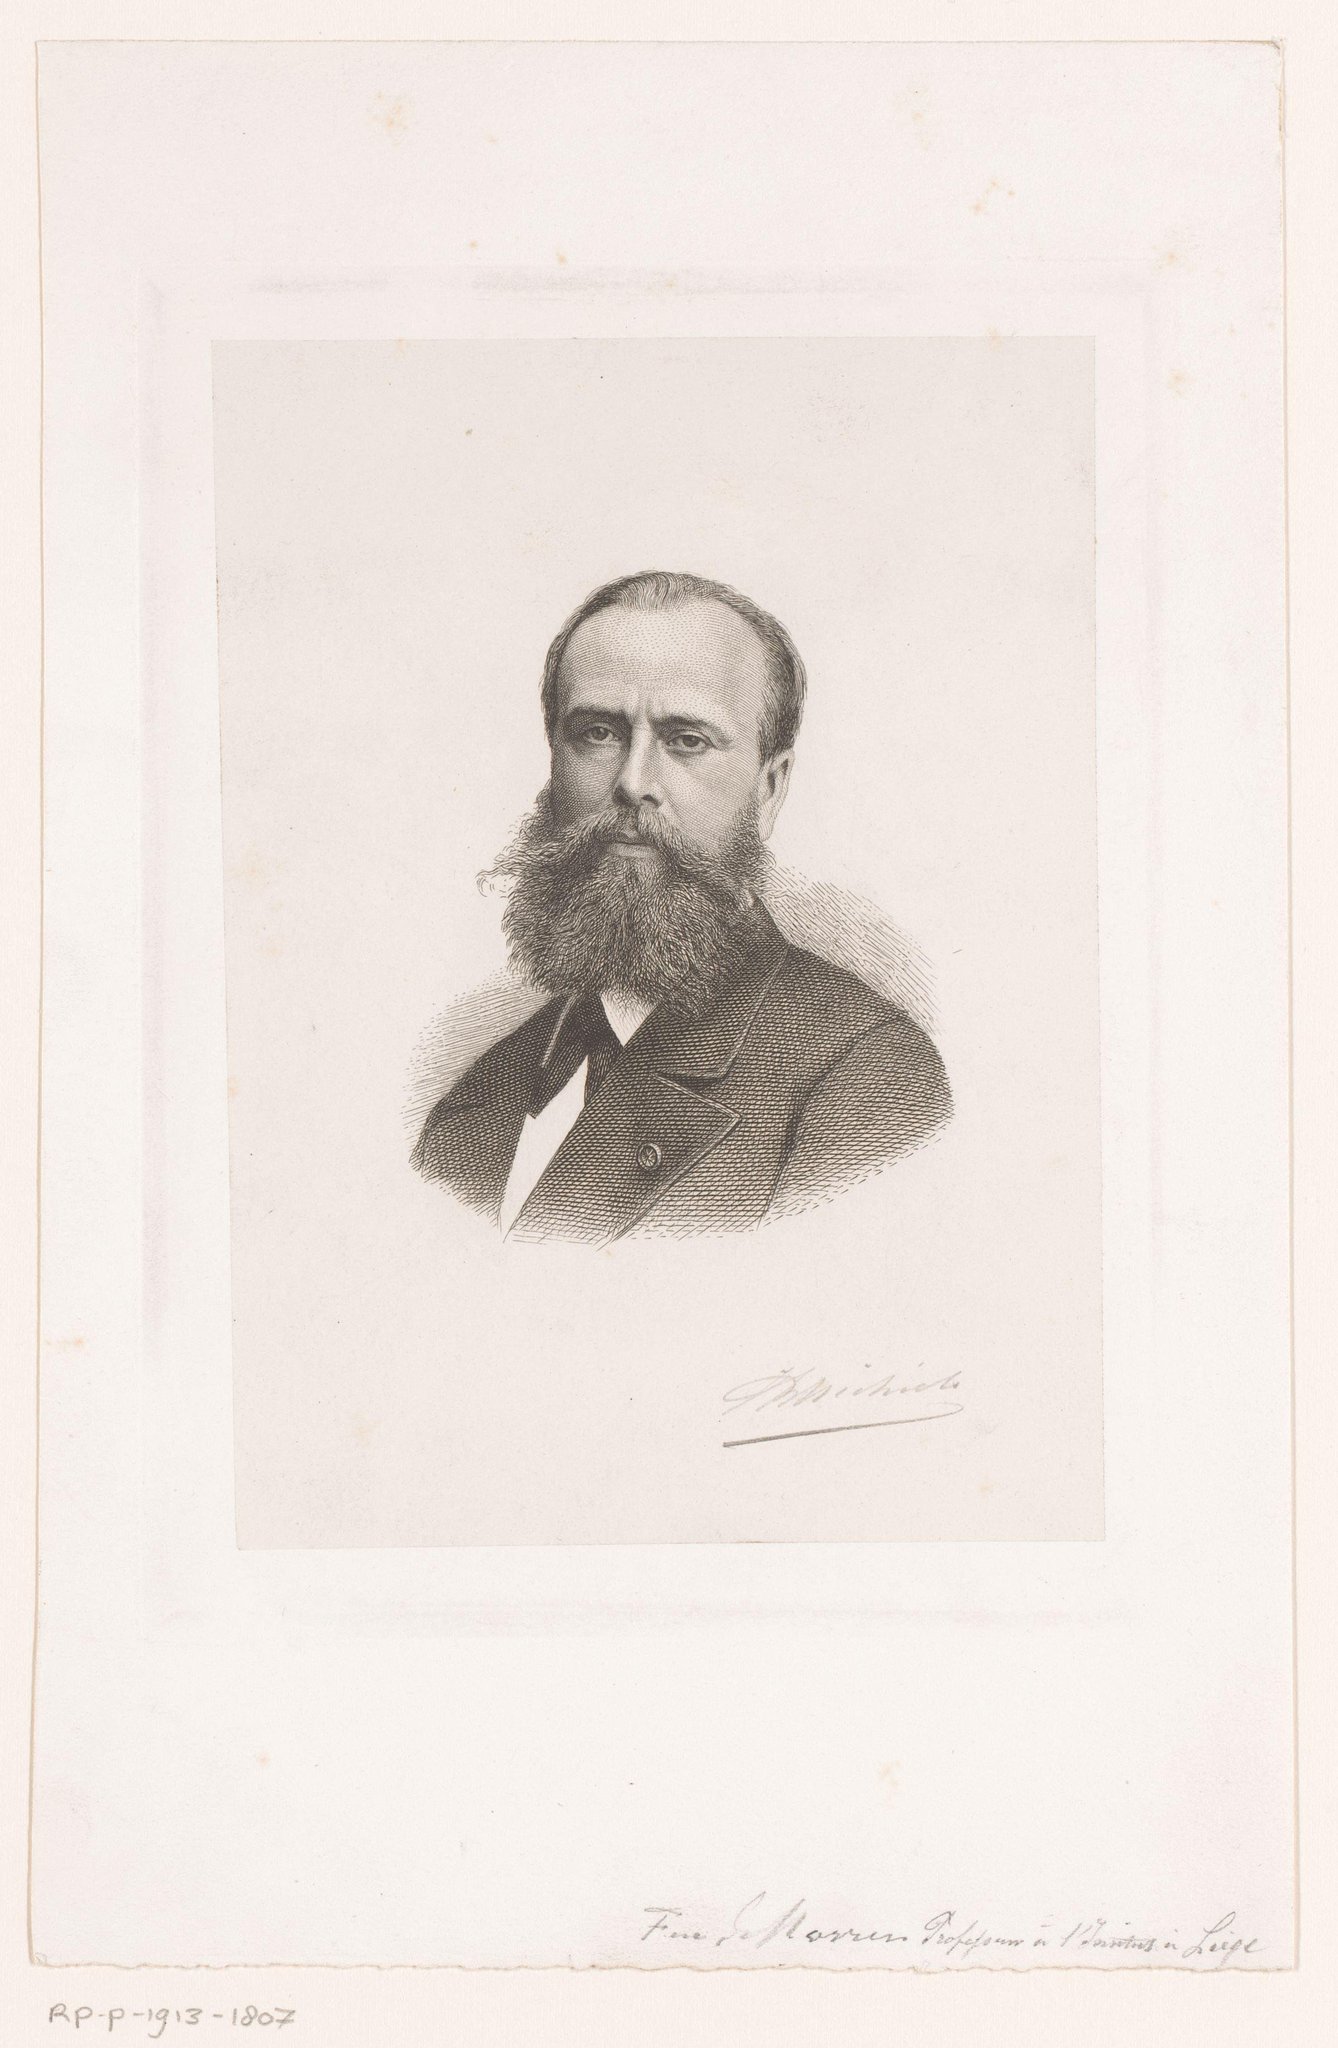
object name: print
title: Portret van Charles Jacques Édouard Morren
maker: jean baptiste pierre michiels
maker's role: print maker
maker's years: 1821-1890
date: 1831-1890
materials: paper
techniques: engraving, etching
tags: adult man, historical persons, beard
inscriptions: collector's mark: Lugt 2228